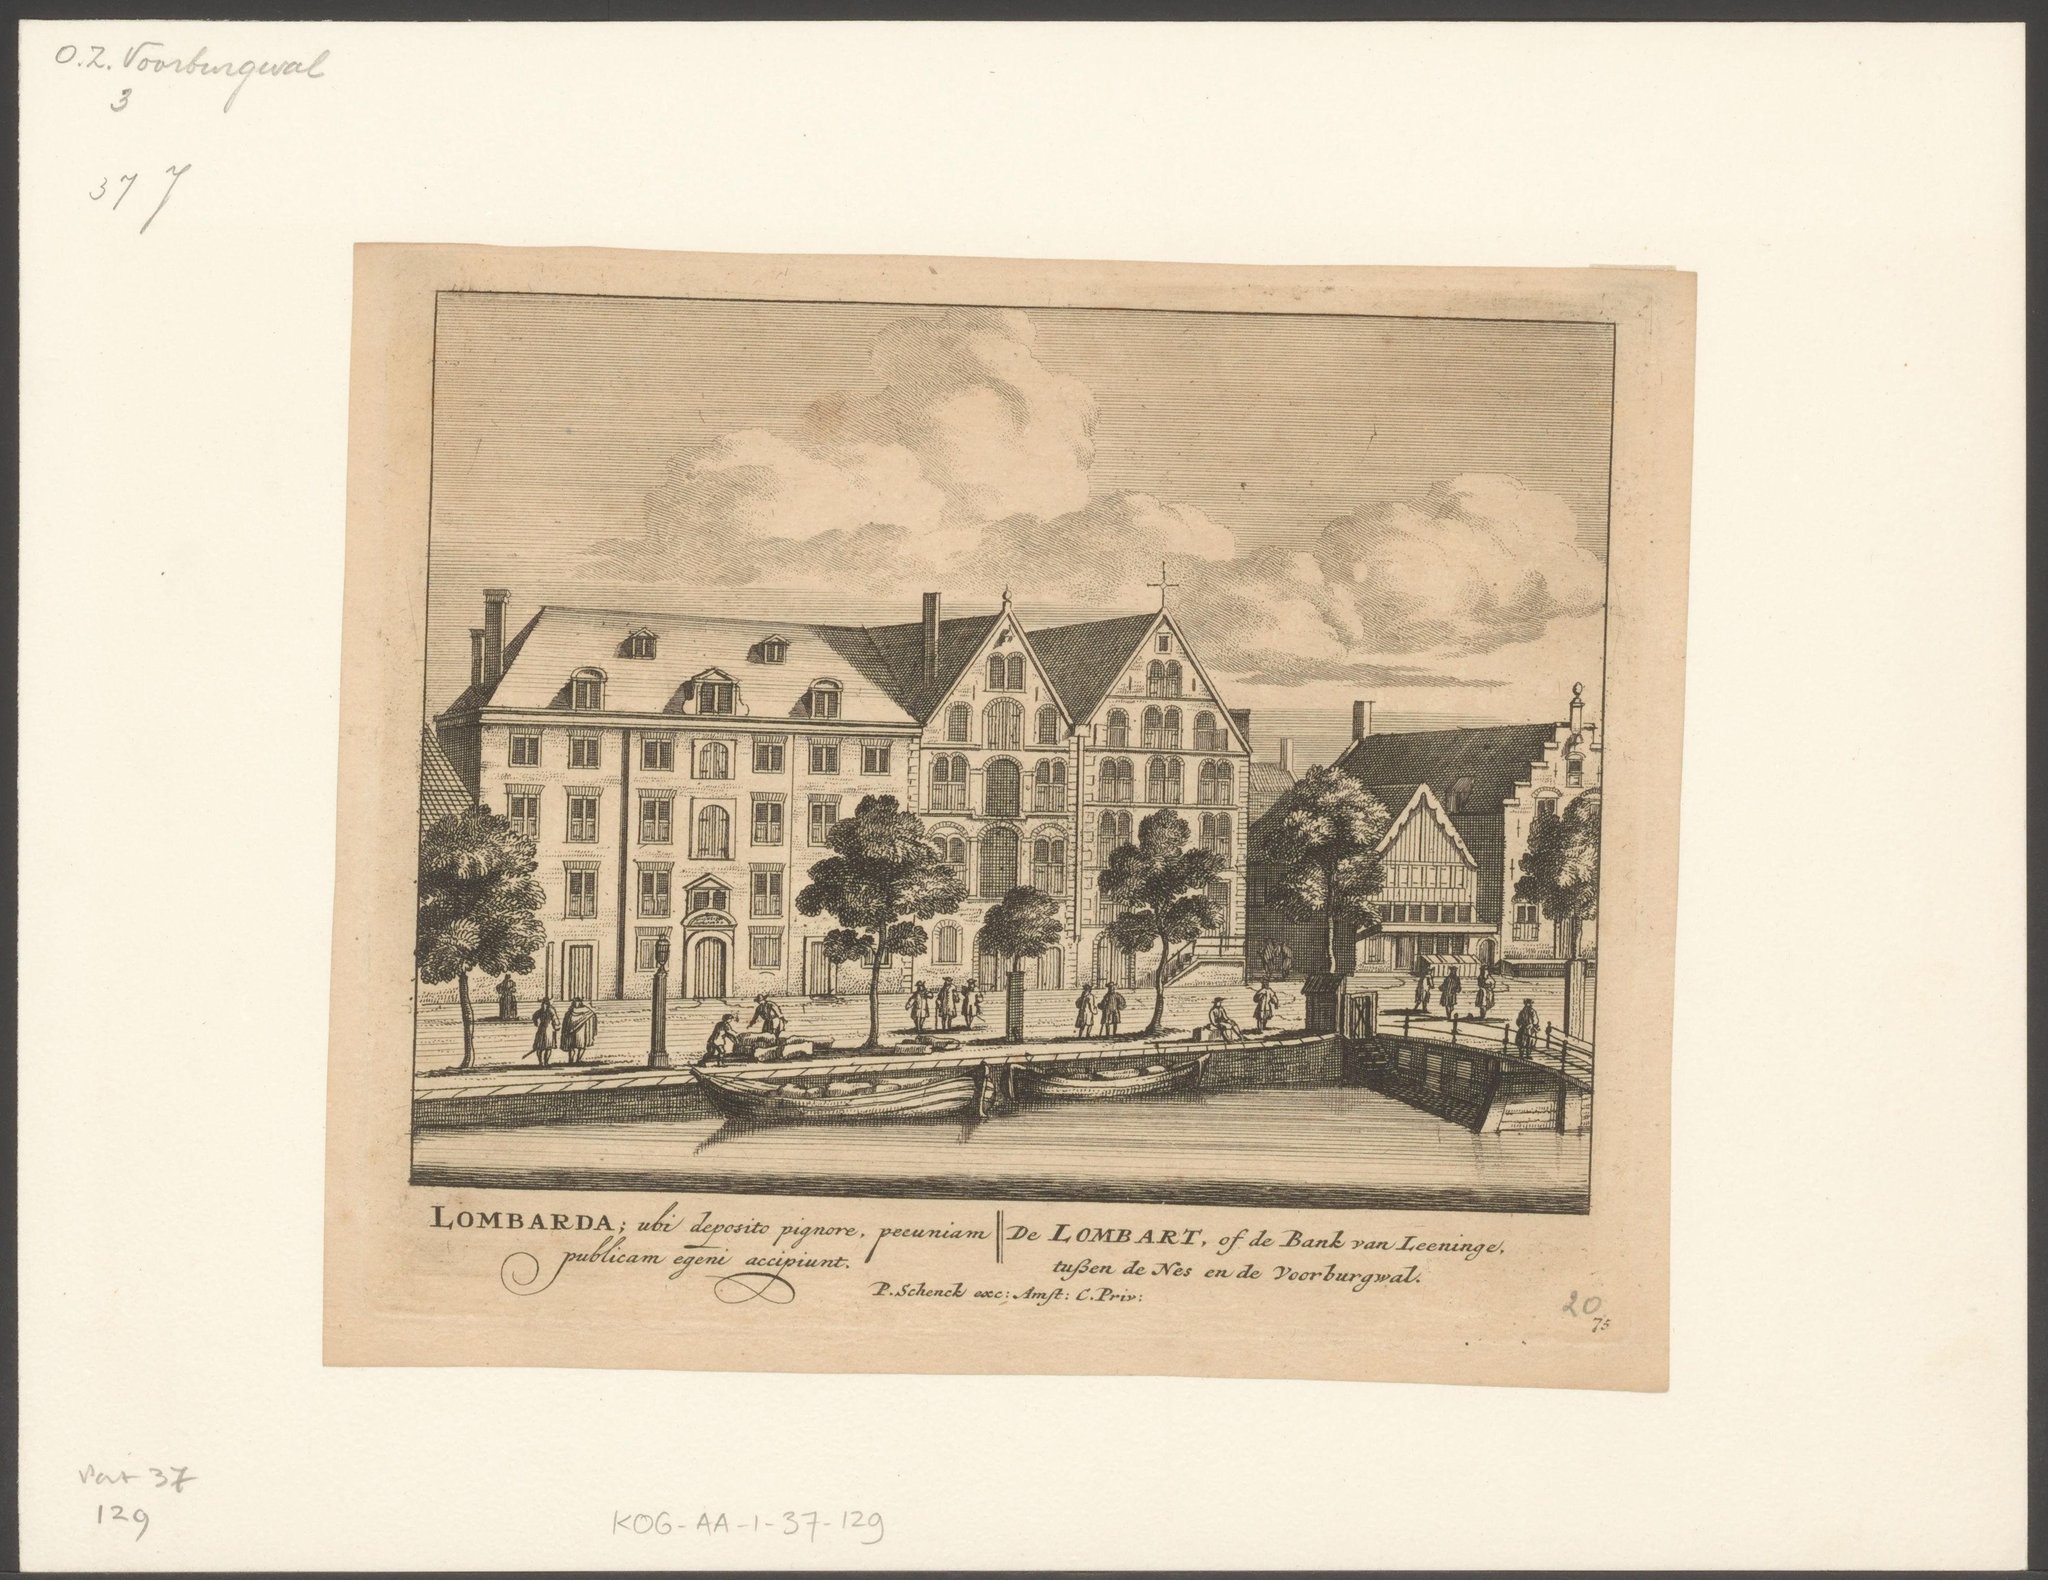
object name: print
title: Lombarda; ubi deposito pignore, pecuniam publicam egeni accipiunt / De Lombart, of de Bank van Leeninge, tussen de Nes en de Voorburgwal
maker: Anonymous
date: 1710-1711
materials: paper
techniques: engraving, etching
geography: northern netherlands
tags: pawnbroker, lombard, bank, canals, waters (in city) (+ city(-scape) with figures, staffage)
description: Prent mogelijk uit: 100 Afbeeldinge der voornaamste gebouwen van Amsterdam. Amsterdam: Pieter Schenk (I), s.a. [1710-1711]. Of uit: 100 Afbeeldinge der voornaamste gebouwen van Amsterdam. Amsterdam: Barent Greve, s.a. [1757-1766]. In de tweede uitgave, uitgegeven door Barent Greve, is alleen de titelprent aangepast. De overige prenten zijn onveranderd gebleven.